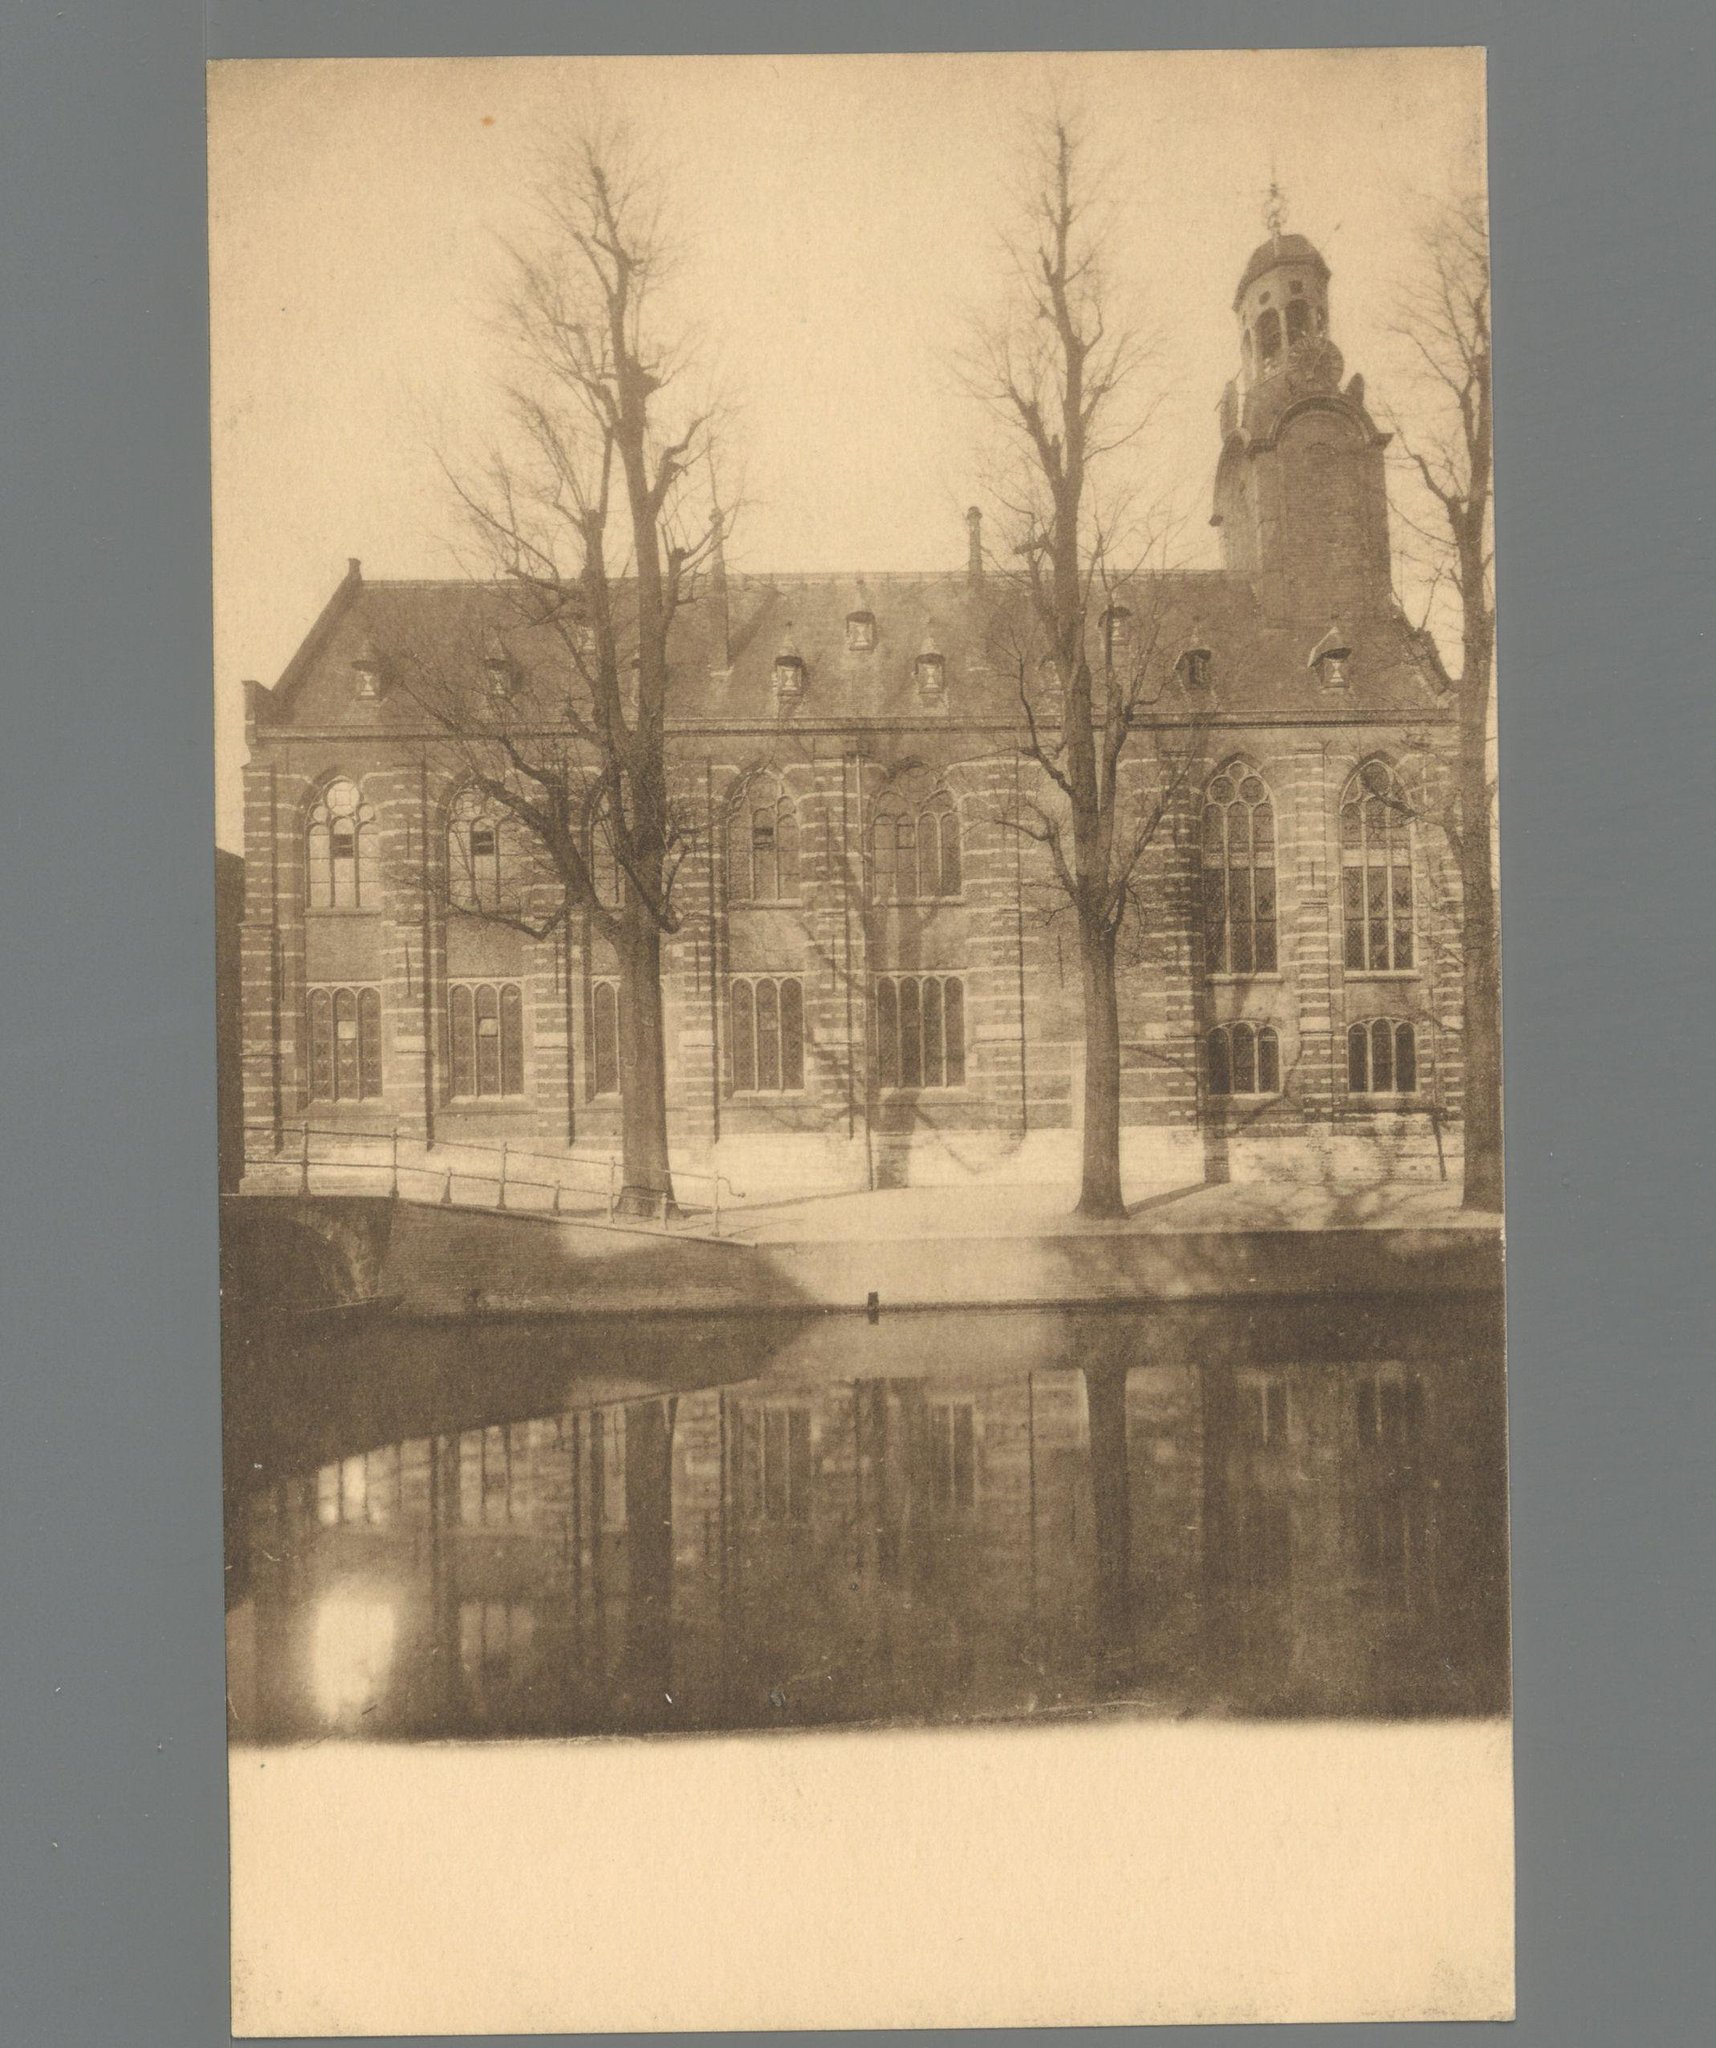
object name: ansichtkaart, prentbriefkaart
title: Leiden. Academie Rapenburg No 73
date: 1905-1930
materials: cardboard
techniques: photograph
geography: leiden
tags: canal, university building, college